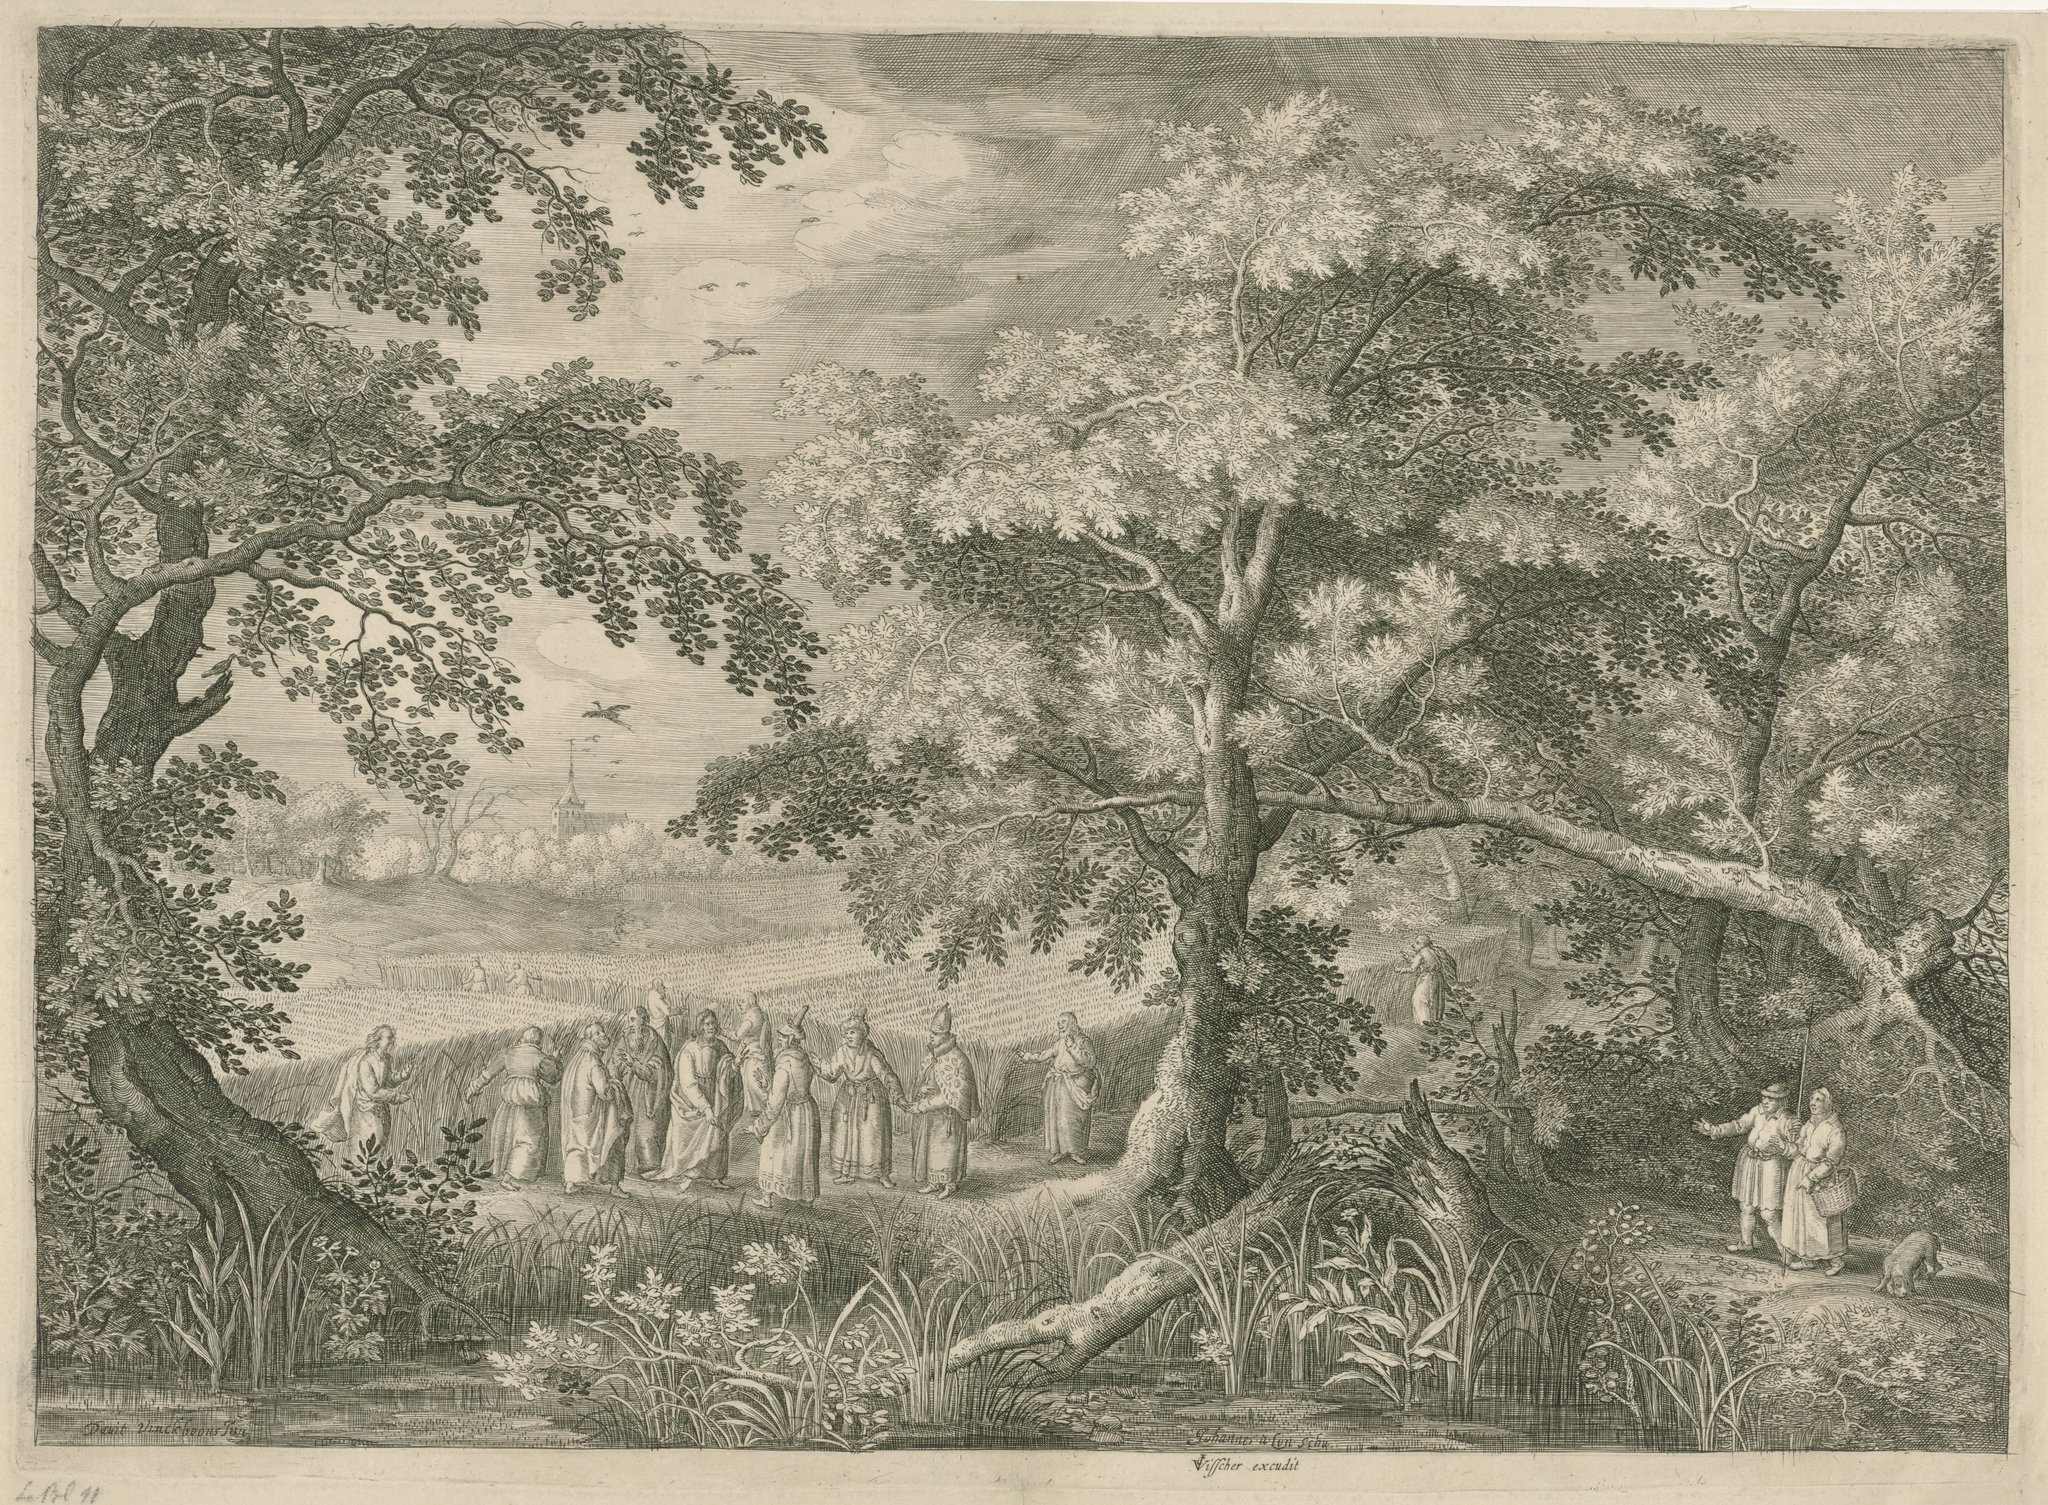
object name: print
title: Landschap met Christus en de discipelen in het korenveld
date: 1601-1652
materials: paper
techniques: engraving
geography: amsterdam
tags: disciples pluck ears of corn on sabbath, and eat (matthew 12:1-8; mark 2:23-28; luke 6:1-5)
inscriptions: collector's mark: Lugt 2228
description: Bosrijk landschap waarin Christus de Farizeeën vertelt dat zijn discipelen de sabbat niet ontwijden als zij zich met korenaren uit het veld tegoeddoen om hun honger te stillen. In het veld plukken de discipelen korenaren. Uiterst rechts kijkt een boeren echtpaar met hond vanaf een afstand toe.